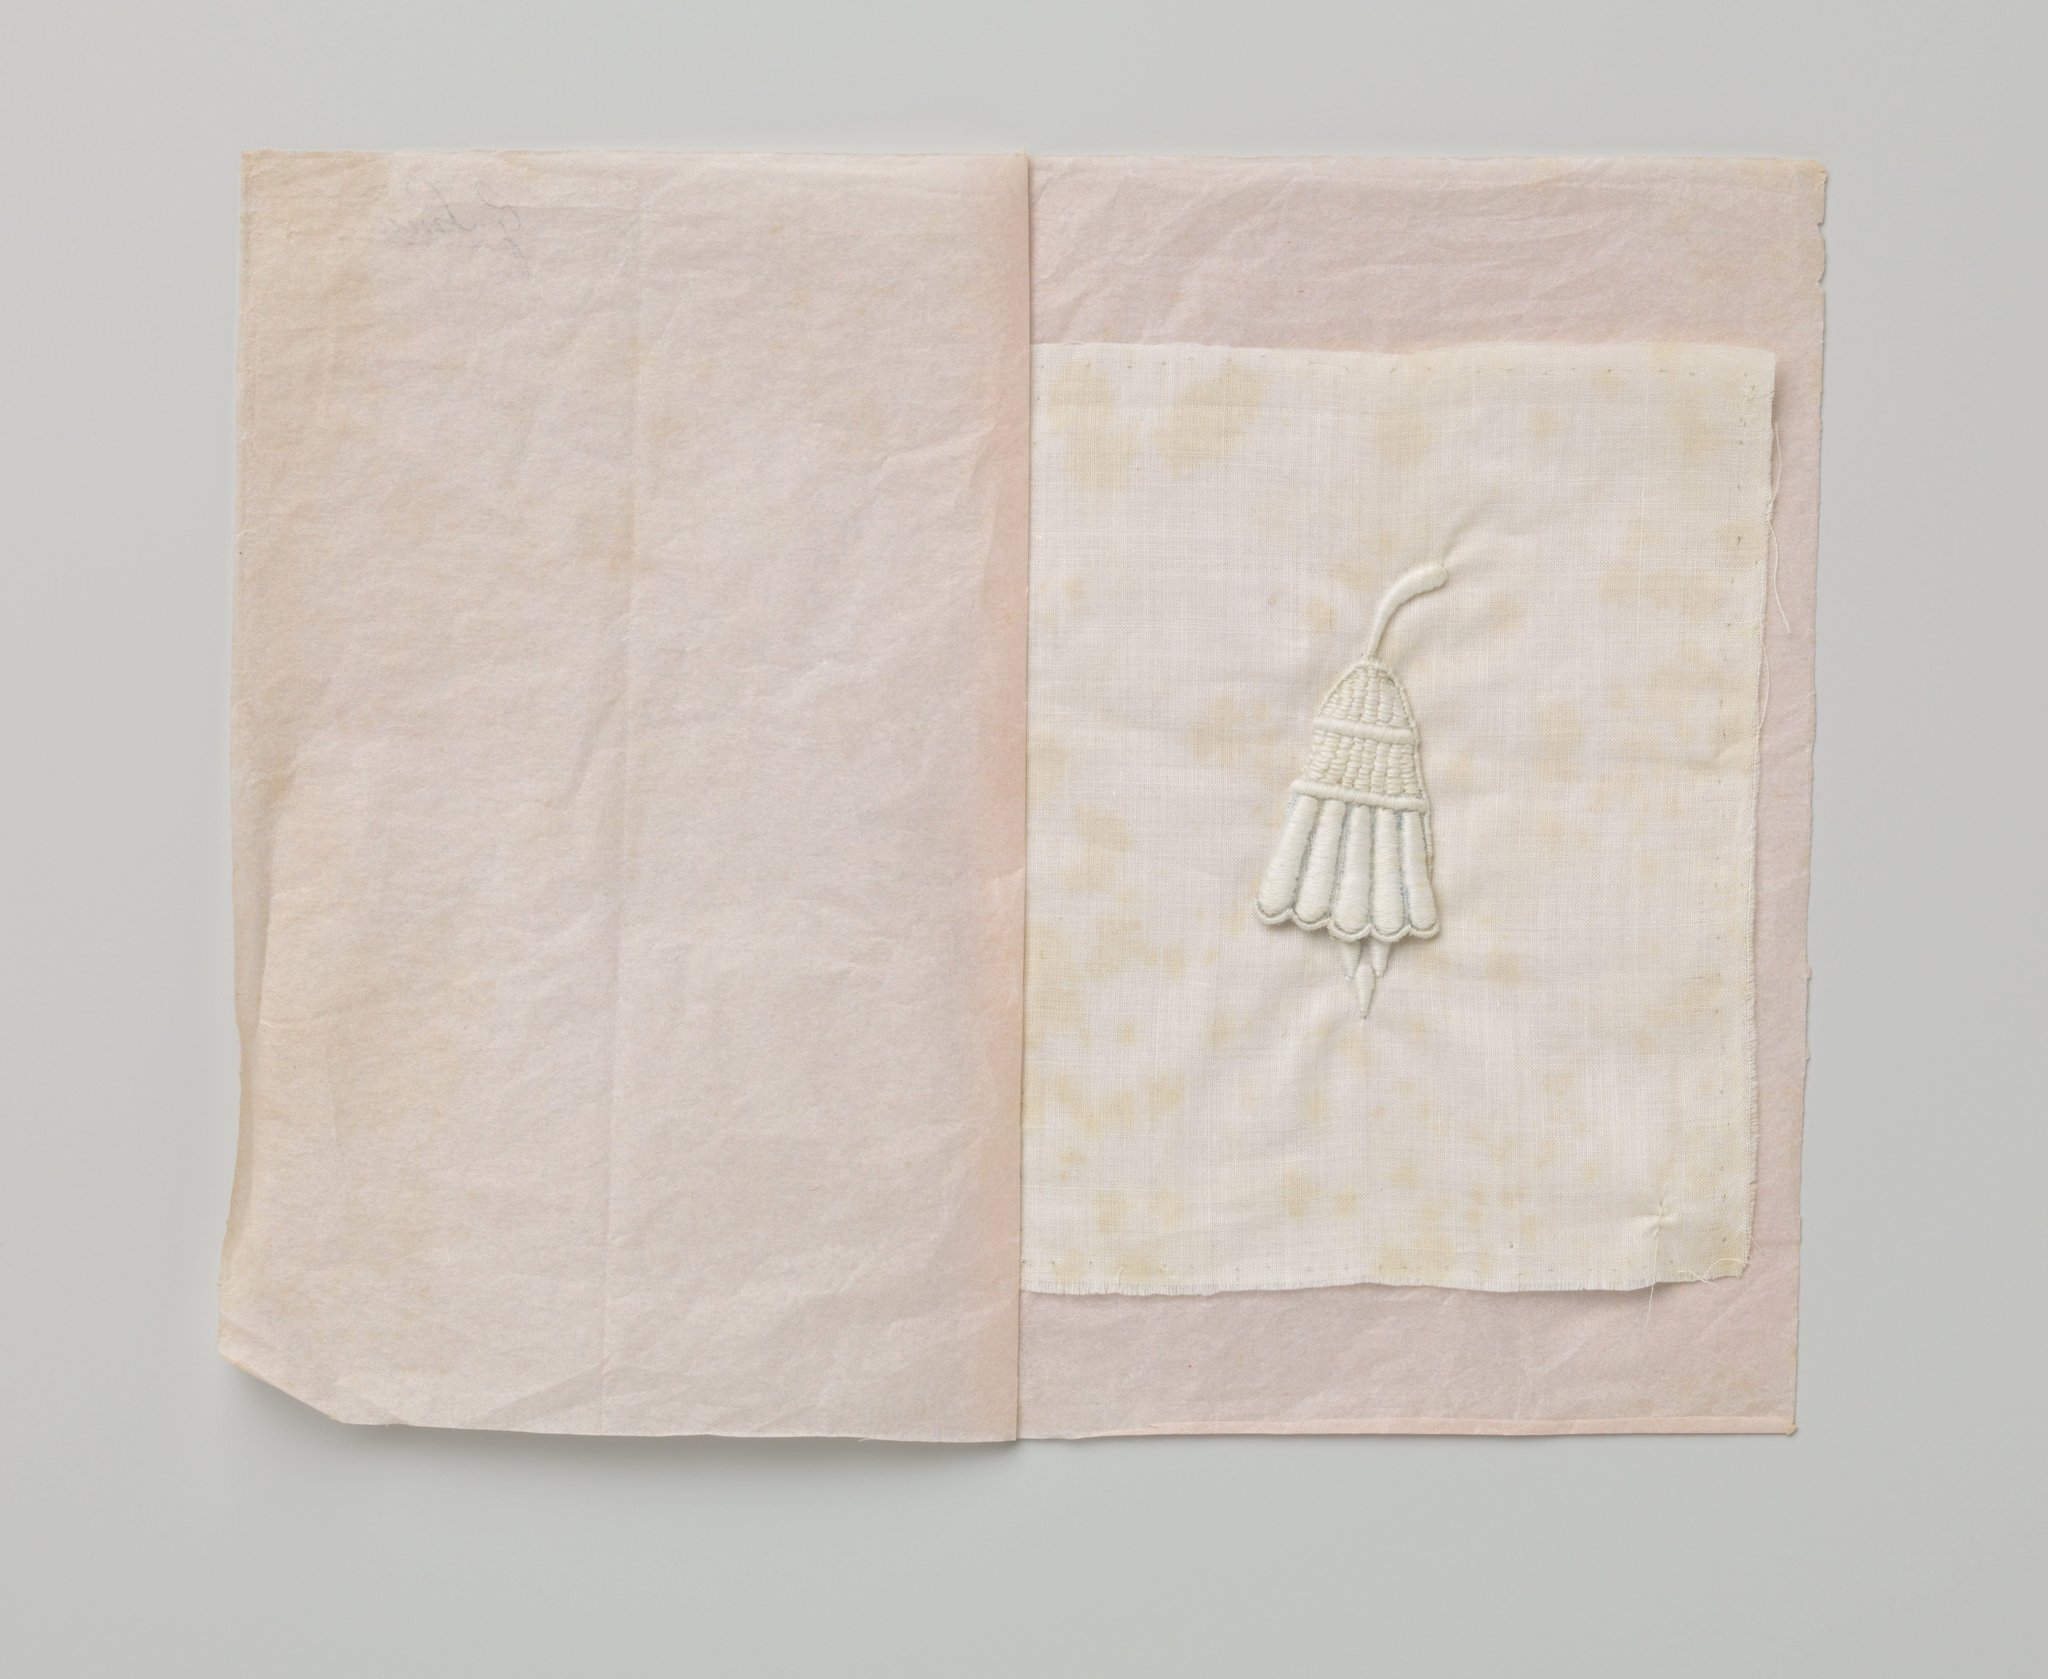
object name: werkstuk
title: Werkstuk voor Diploma fraaie handwerken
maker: geesje smid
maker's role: artisan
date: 1890-1900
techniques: embroidered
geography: netherlands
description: Stuk batist met klokbloempje in plumetis borduurwerk.